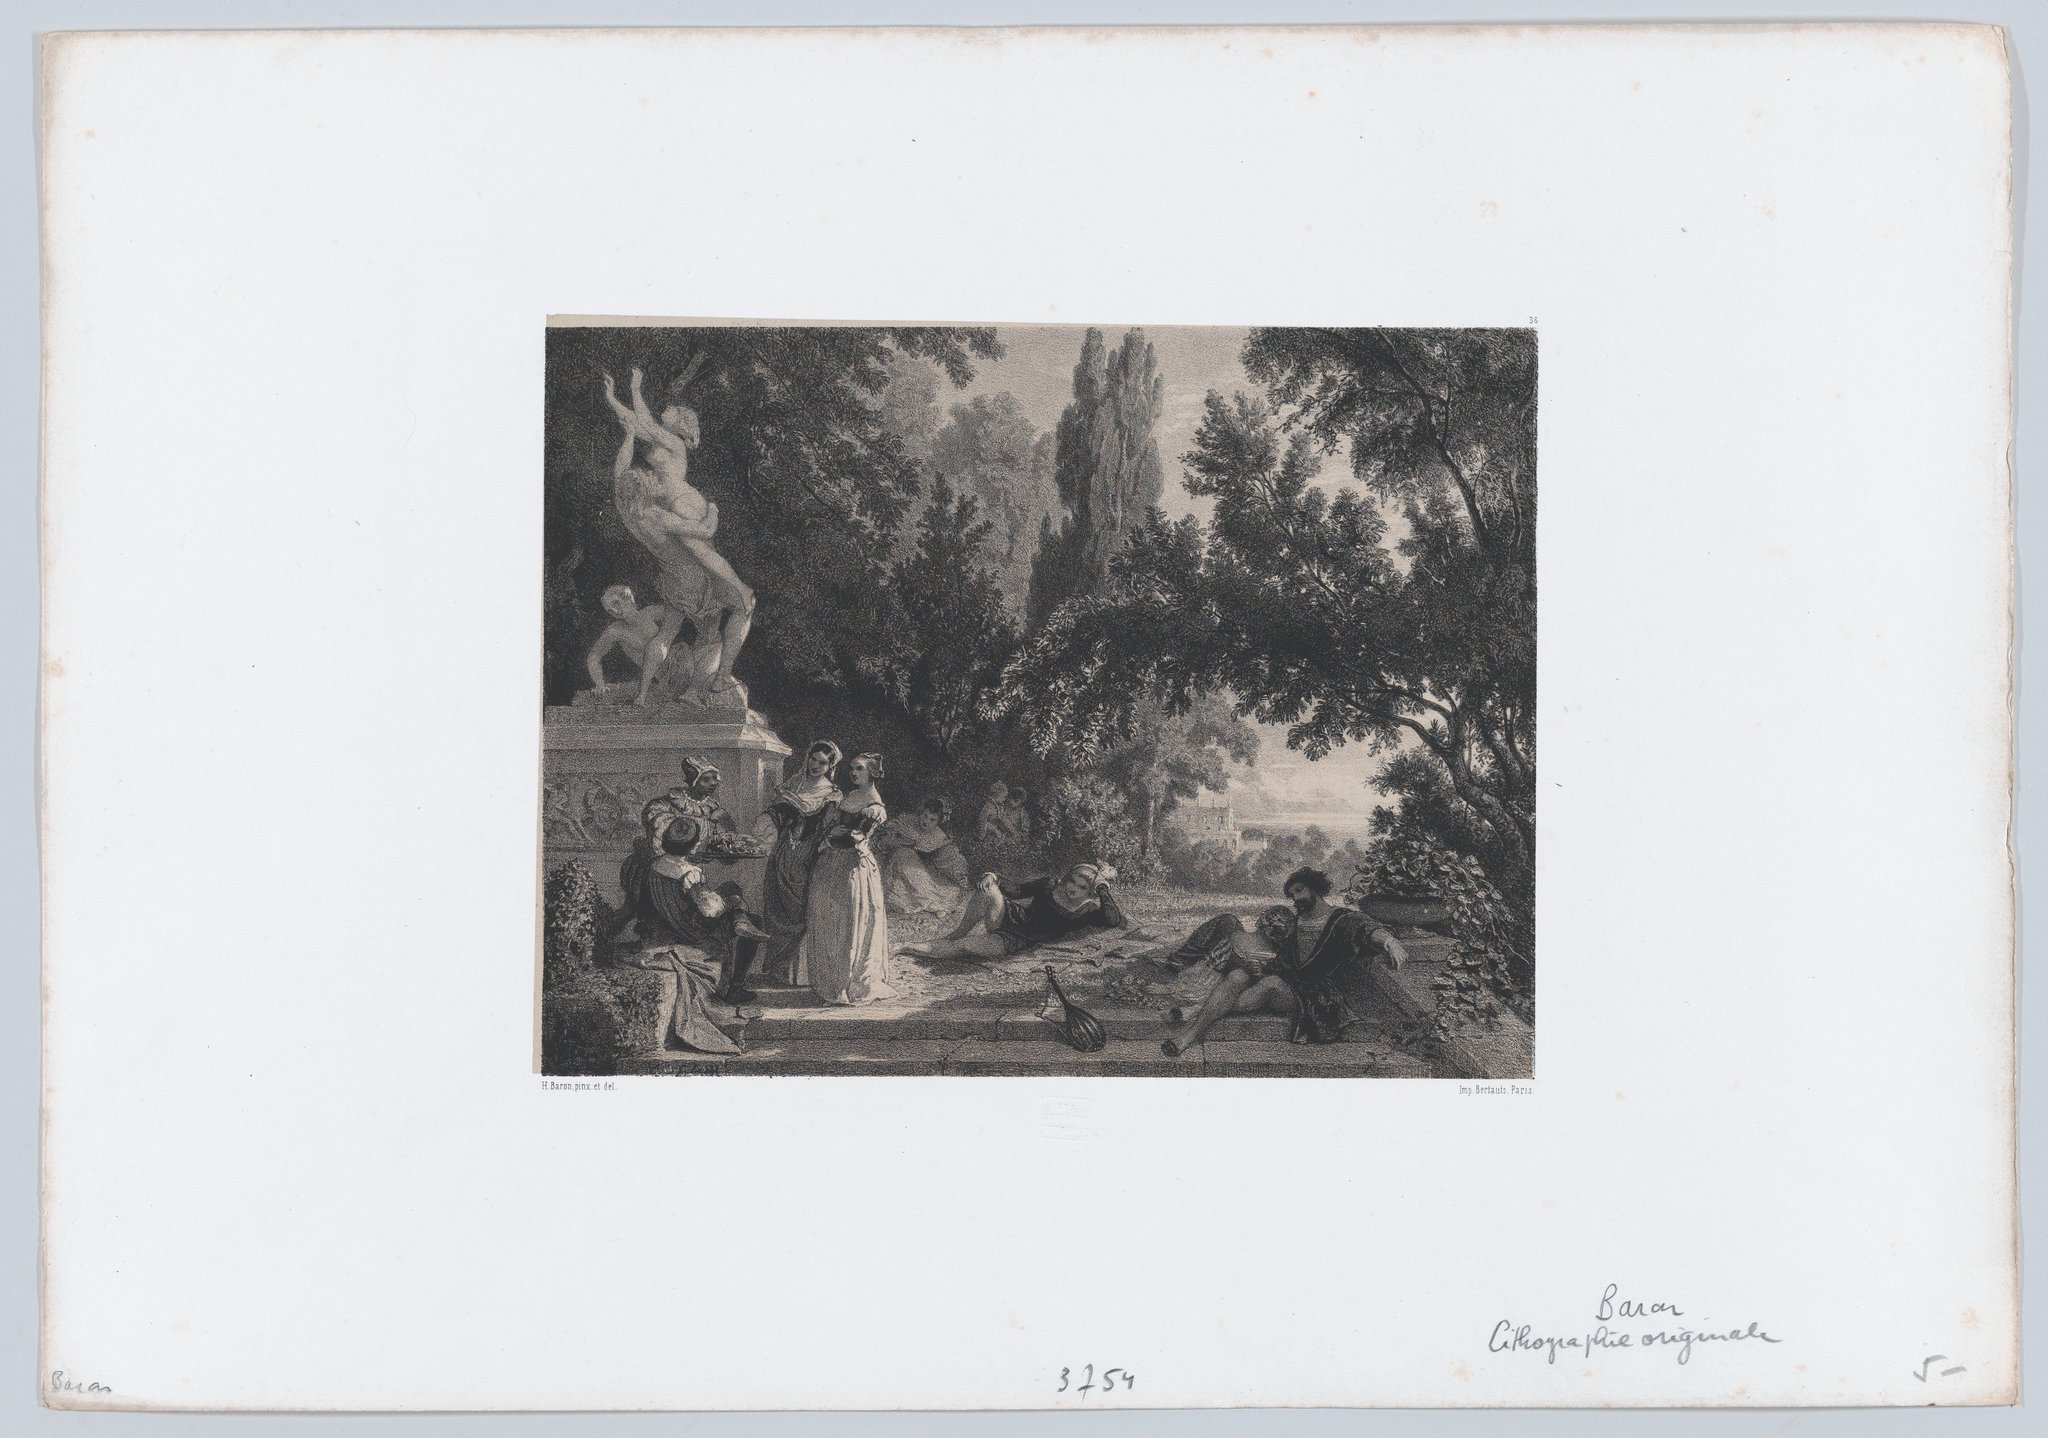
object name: print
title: Summer Night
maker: henri-charles-antoine baron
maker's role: artist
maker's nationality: french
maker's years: 1816-1885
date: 1853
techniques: printmaking, lithograph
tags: men,women,summer,night